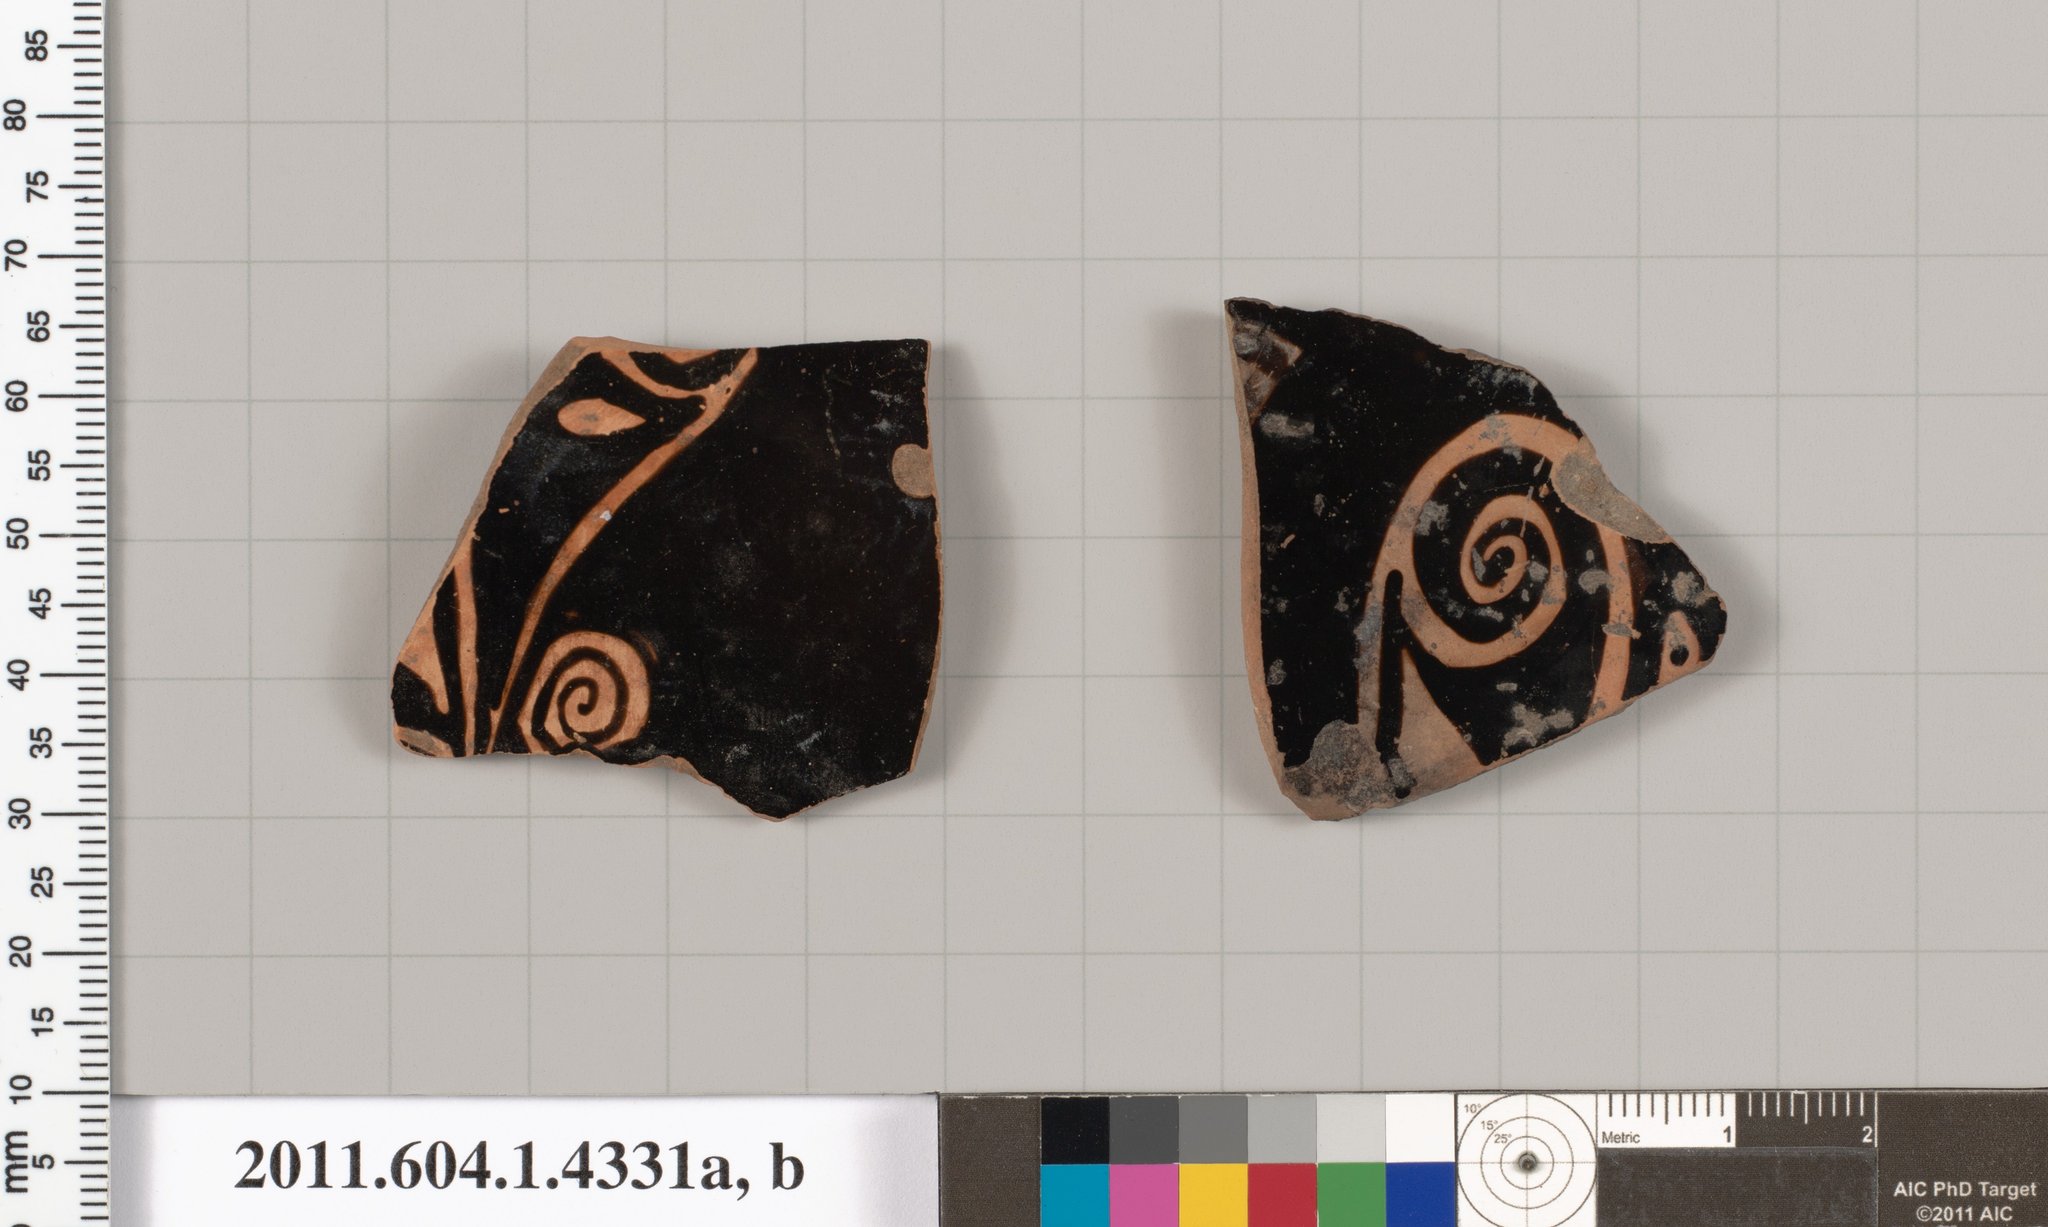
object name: kylix fragment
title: Terracotta fragments of kylikes (drinking cups)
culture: greek, attic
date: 475-451 BCE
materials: terracotta